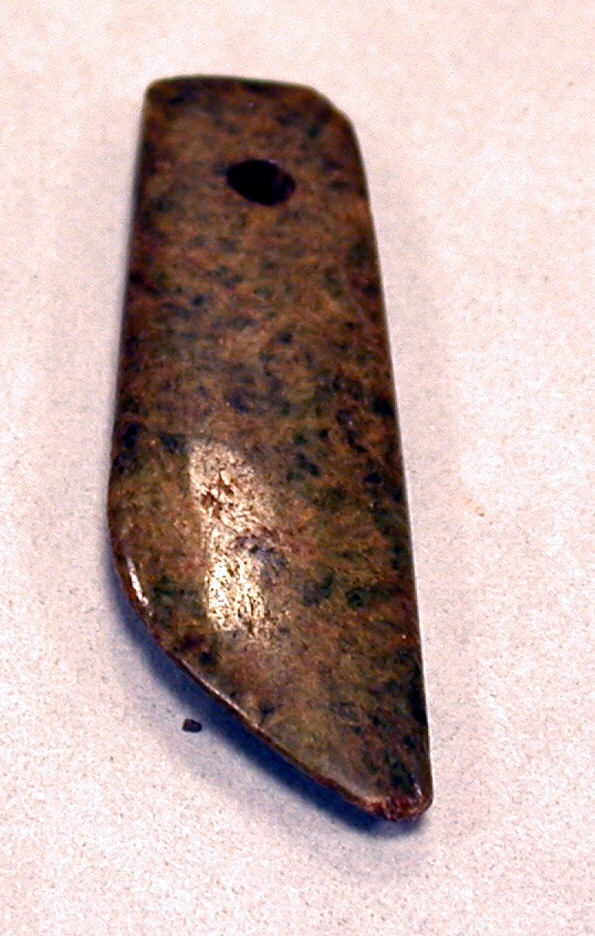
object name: pendant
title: Celt Shaped Pendent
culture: costa rican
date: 801-1500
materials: stone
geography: costa rica